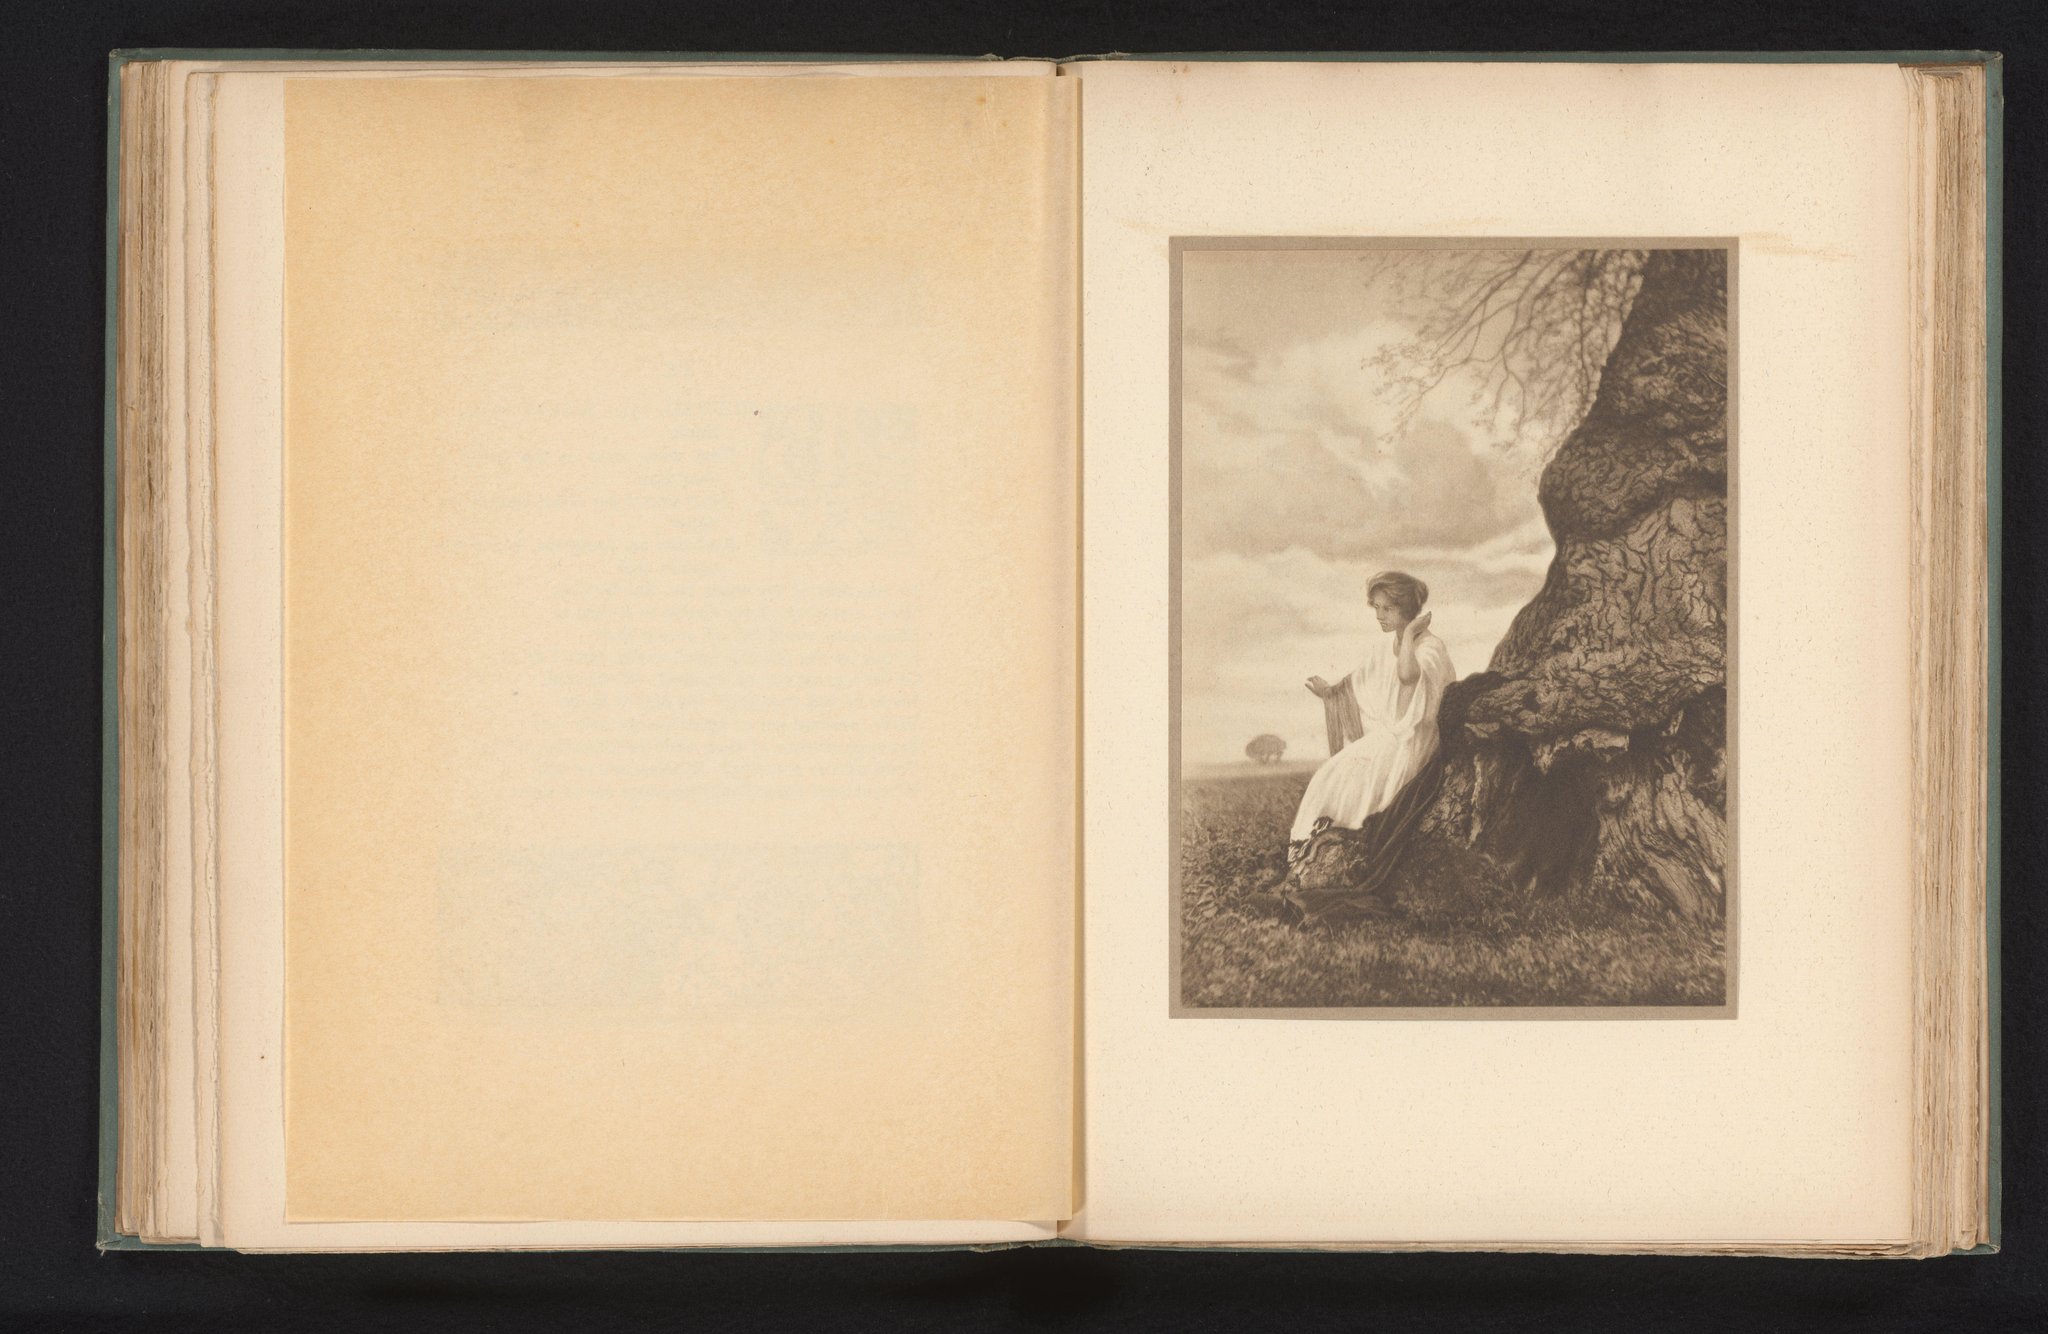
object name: photomechanical print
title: Vrouw zittend op de wortel van een boom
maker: adelaide hanscom leeson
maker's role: painter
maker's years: 1875-1931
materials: cardboard, paper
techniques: photoaquatint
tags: adult woman, trees (+ root, tuber)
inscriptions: copyright notice: ‘C’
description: Prent op ongenummerde pagina. Adelaide Hanscom Leeson manipuleerde haar glasnegatieven om een schilderachtig efffect te bewerkstelligen.